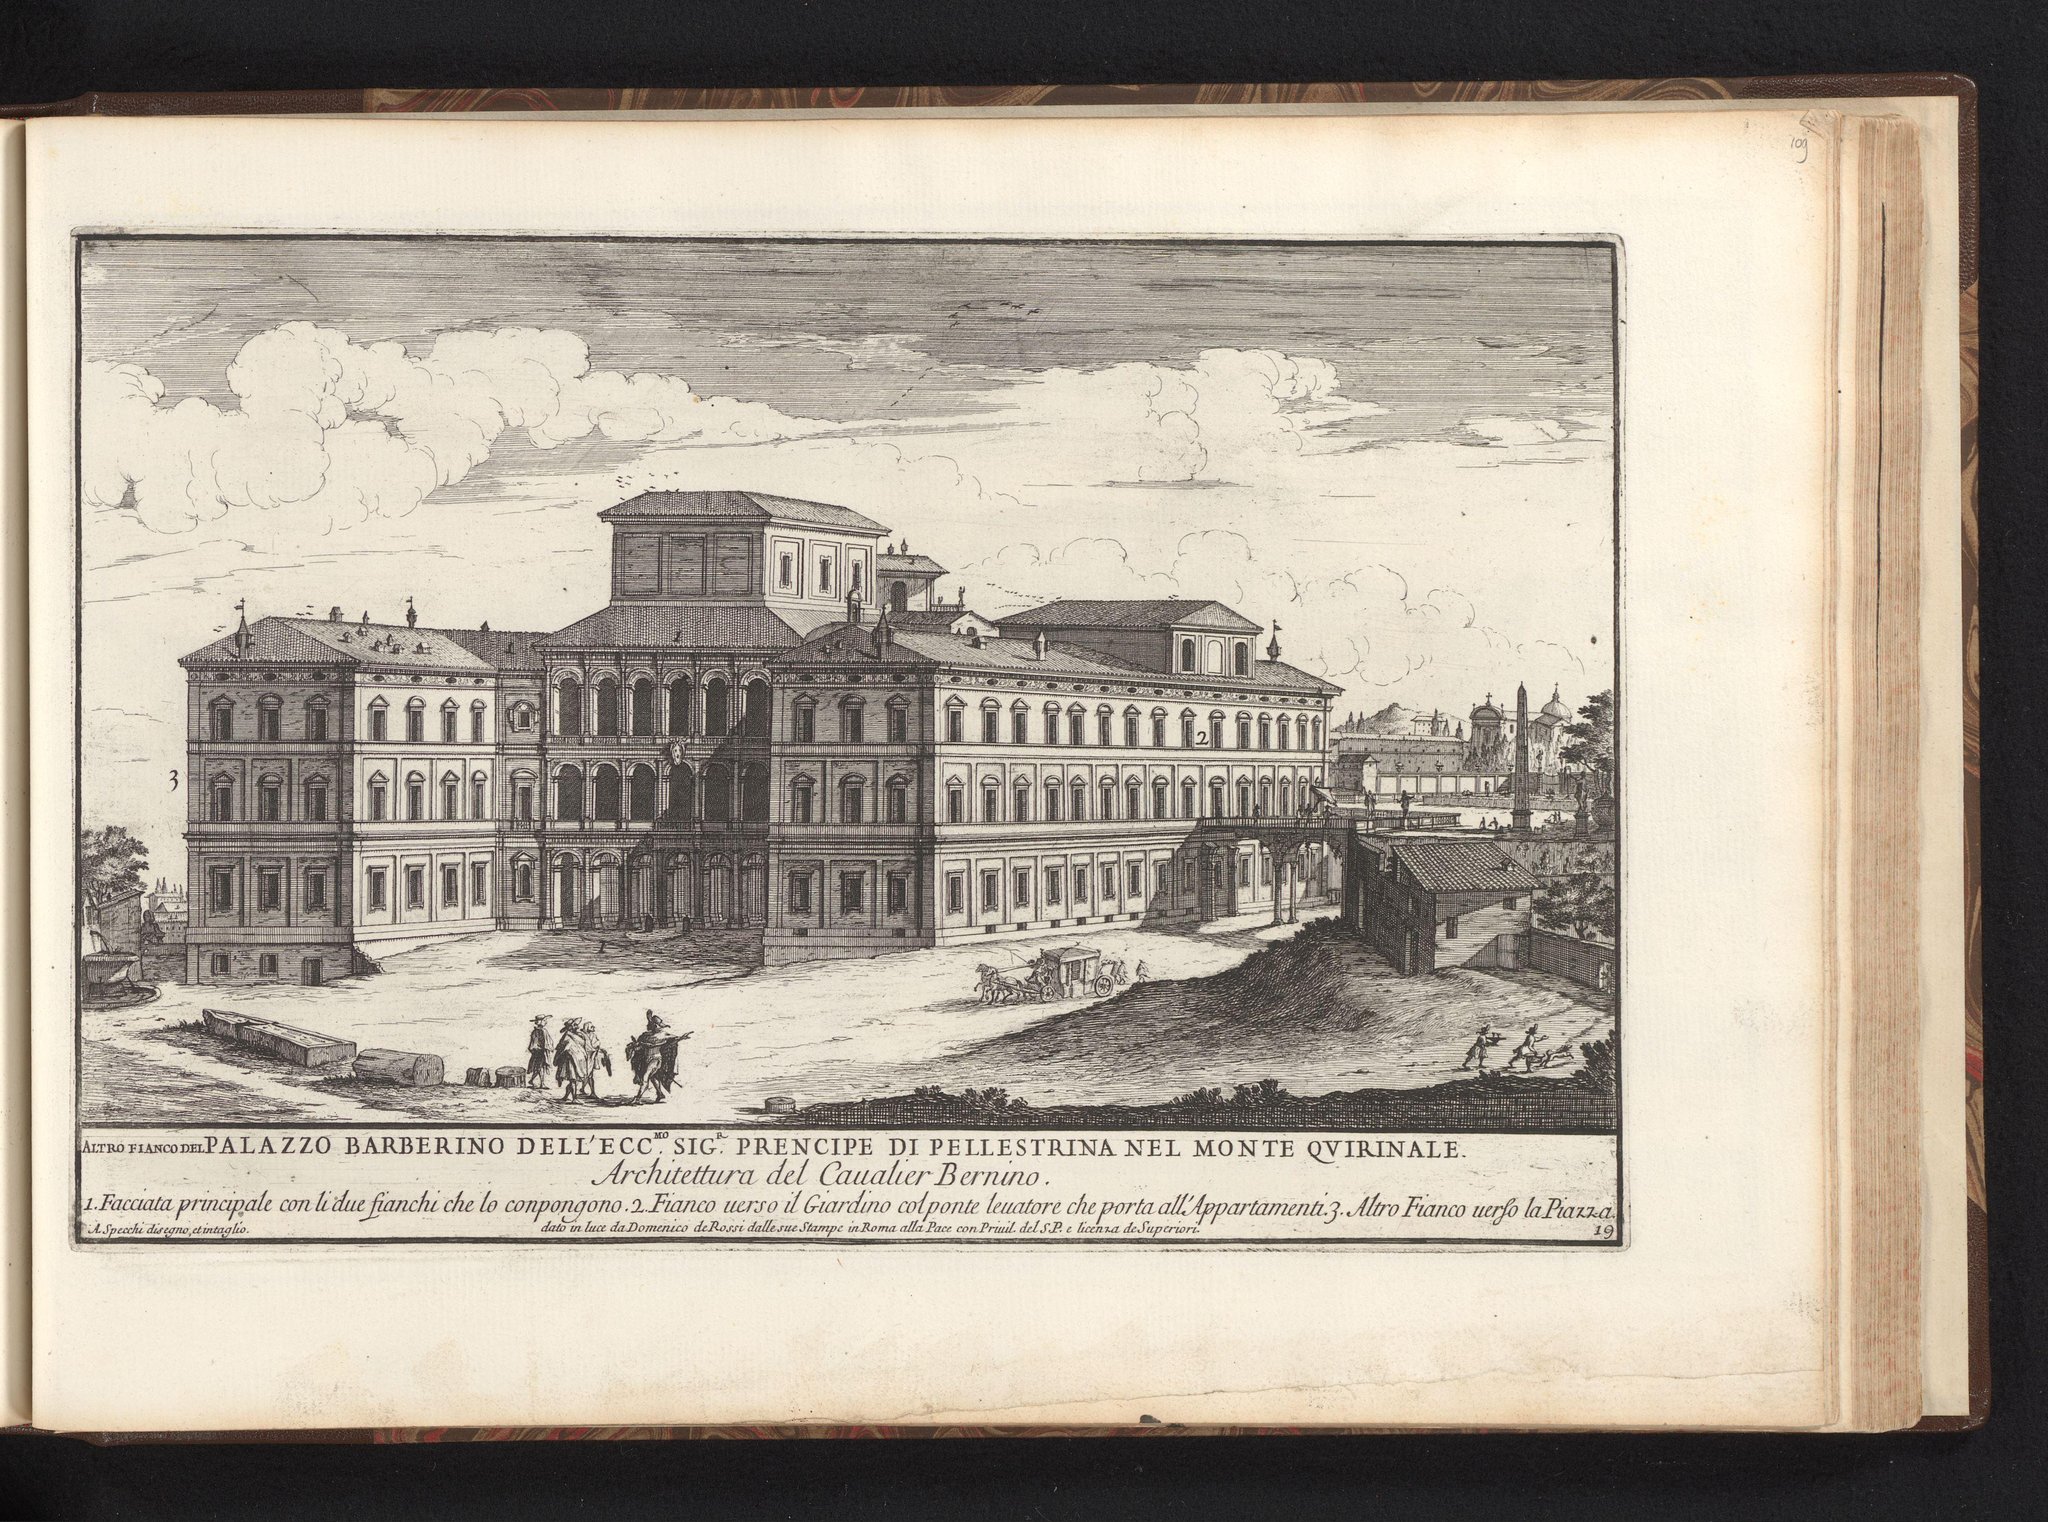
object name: print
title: Moderne gebouwen te Rome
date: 1699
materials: paper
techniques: etching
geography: rome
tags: city-view, and landscape with man-made constructions, hôtel, i.e. small palace in city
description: Deze prent maakt deel uit van een reeks van 52 prenten met voorstellingen van paleizen in Rome. Samen met vier andere reeksen vormt het de grote reeks: 'Il nuovo teatro di Roma moderna'.